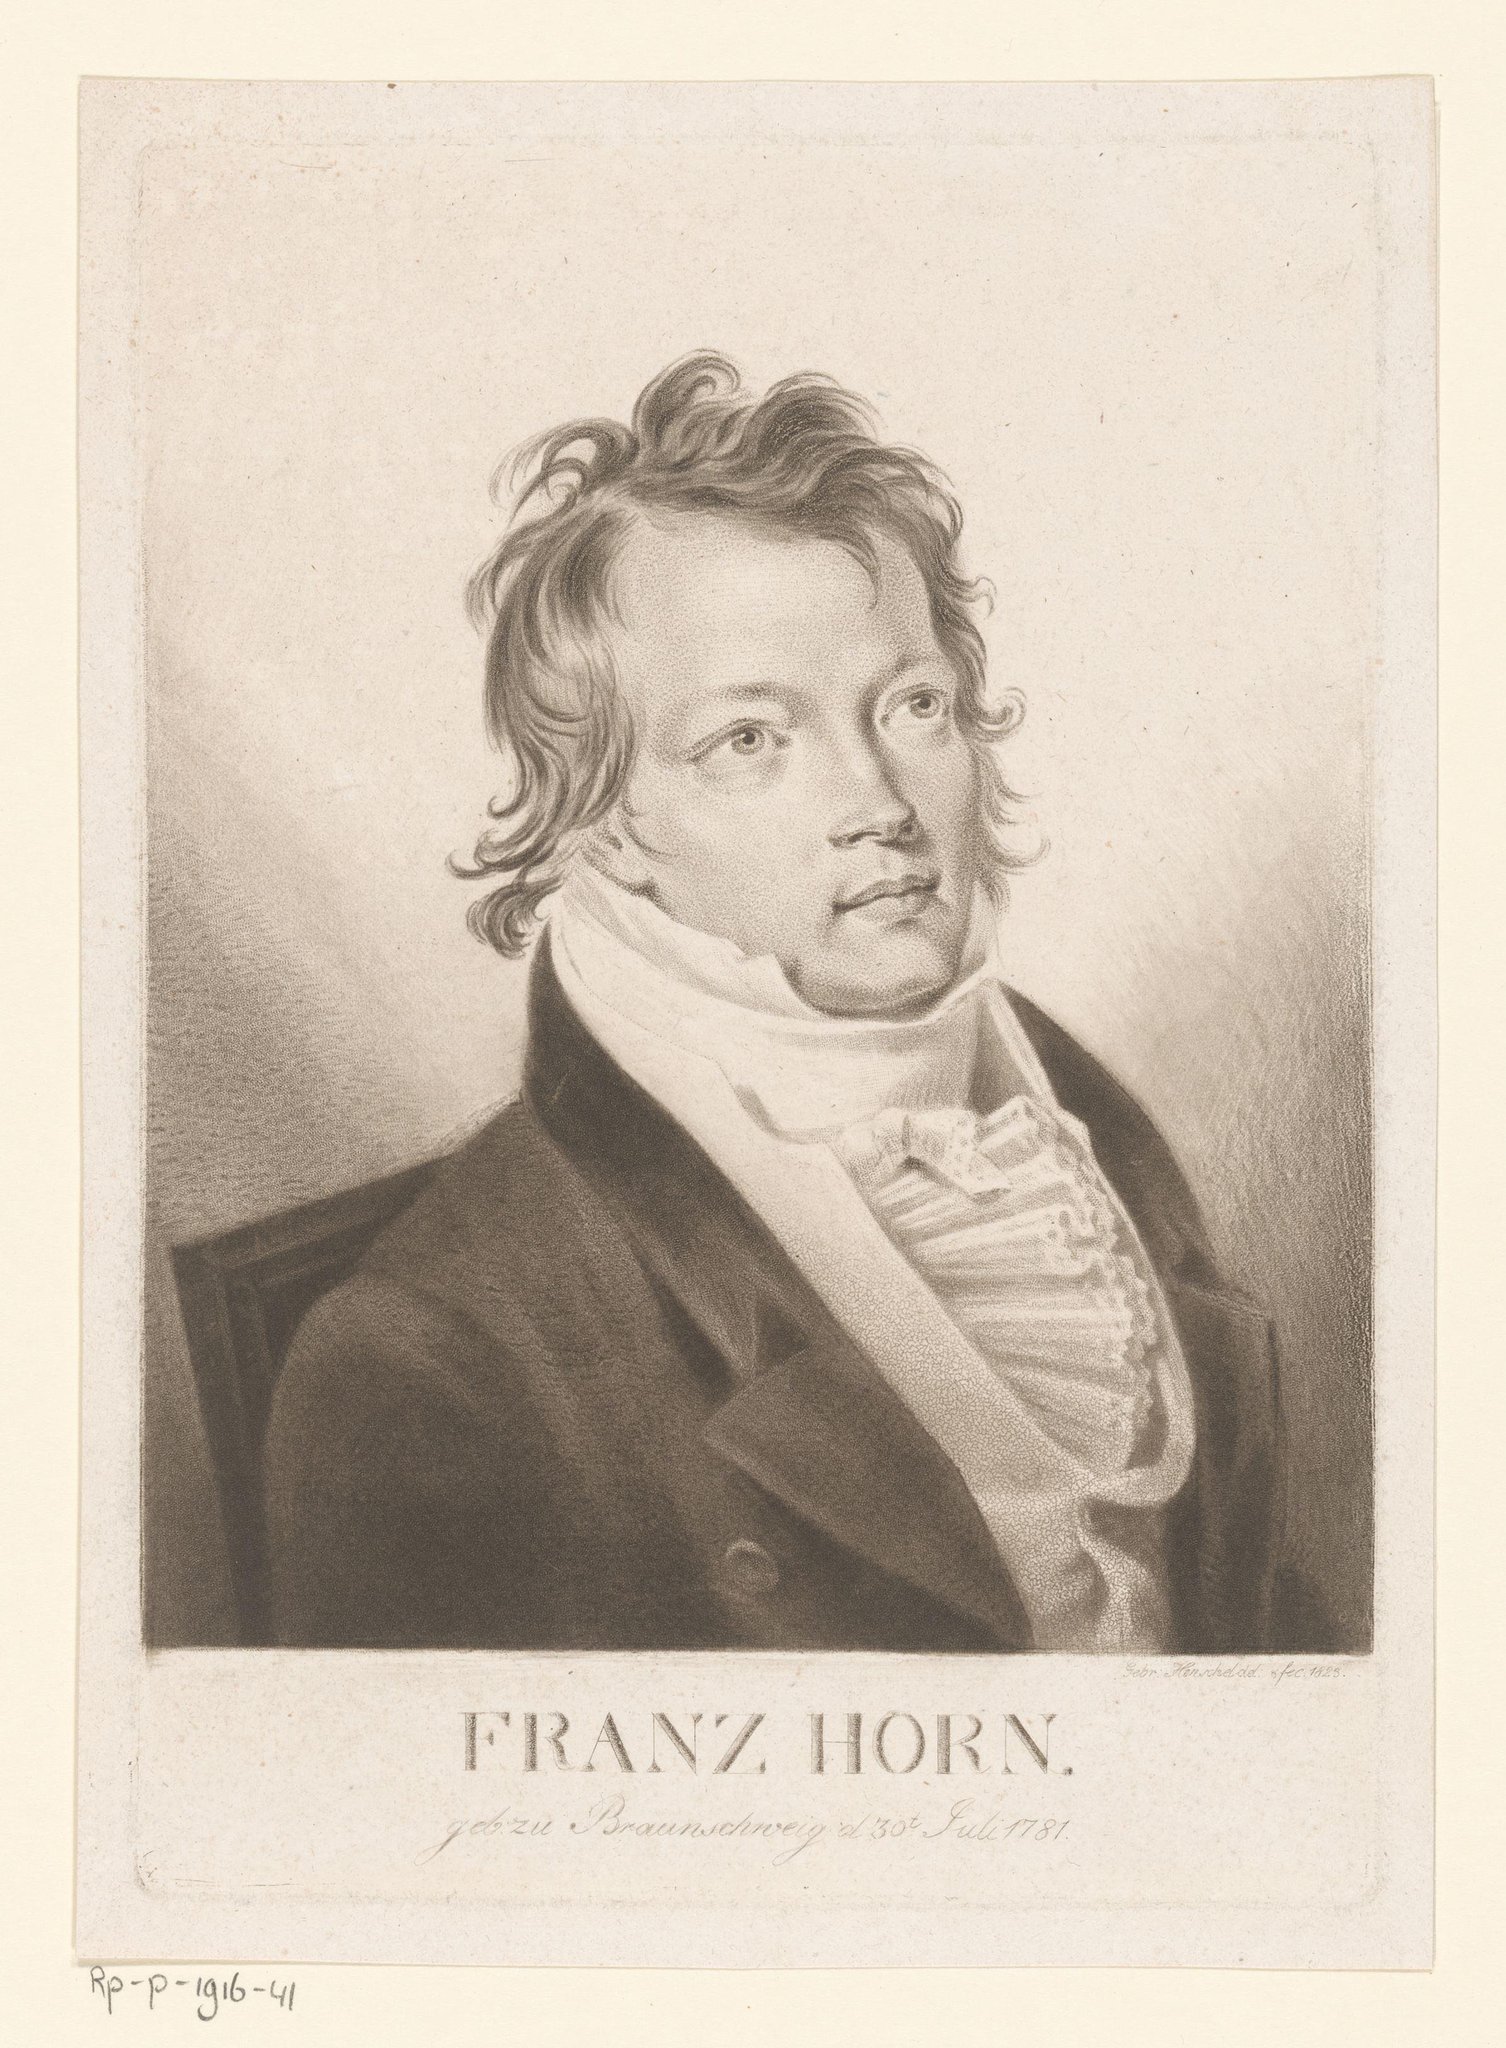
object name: print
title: Portret van Franz Horn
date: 1823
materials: paper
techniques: etching, roulette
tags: berlin, historical persons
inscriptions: collector's mark: Lugt 2228